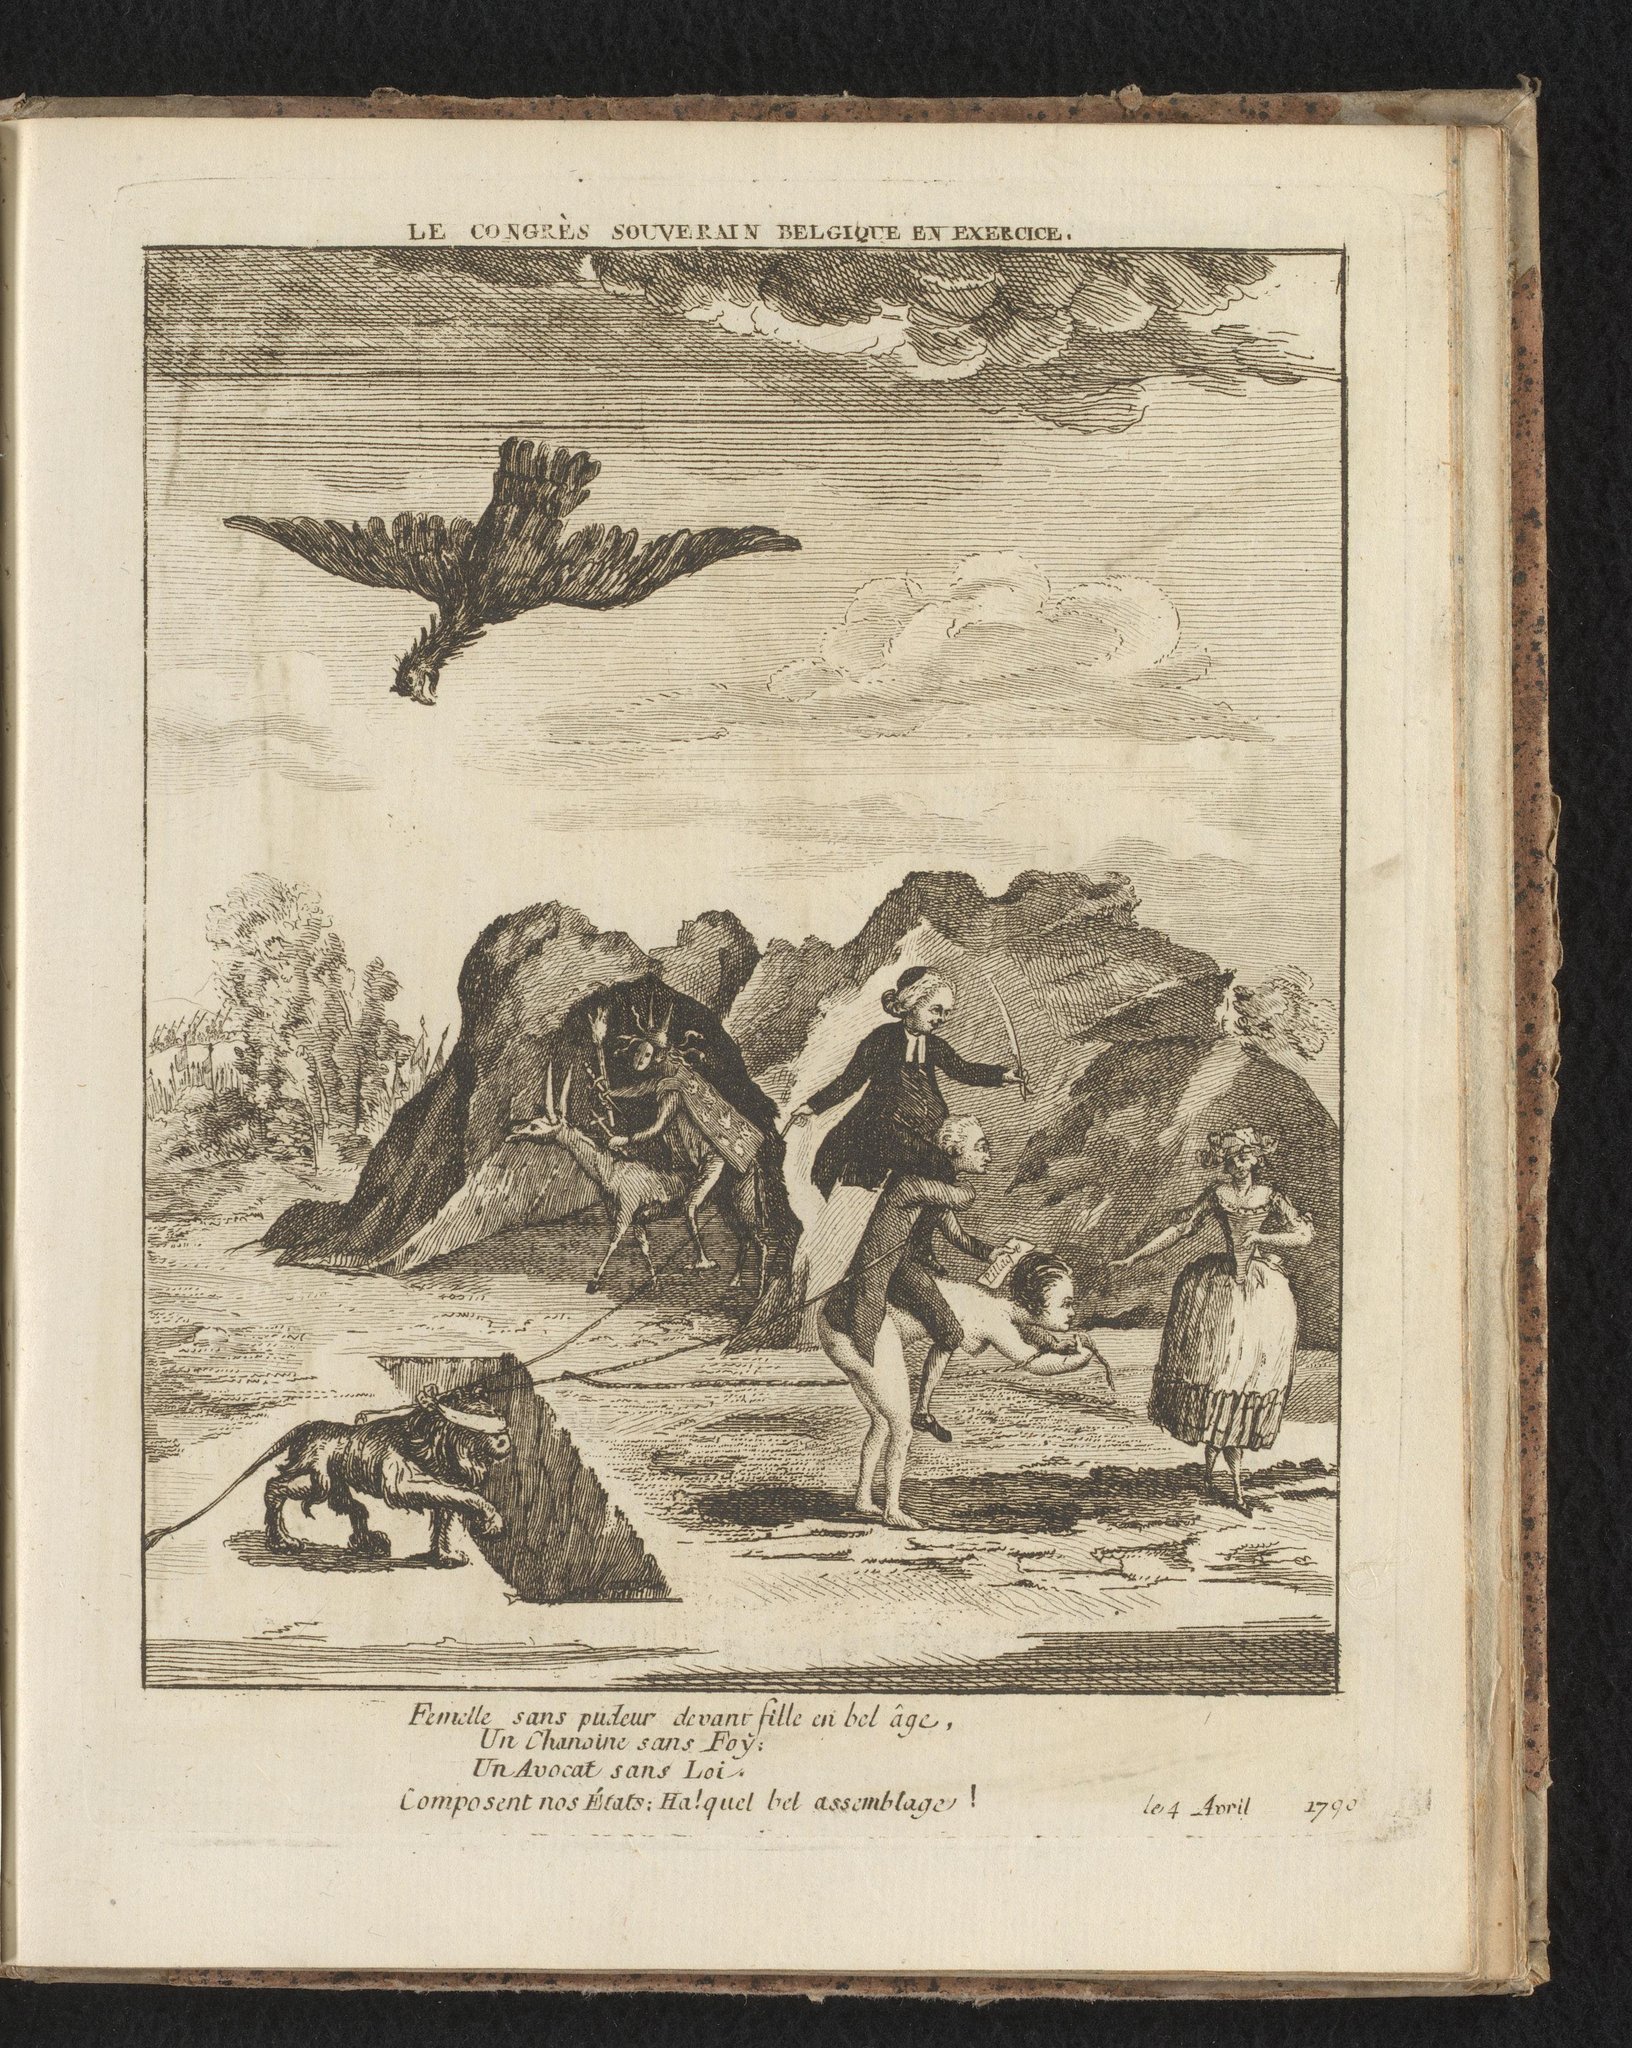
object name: cartoon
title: Le Congrès Souverain Belgique en Exercice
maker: Anonymous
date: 1787-1790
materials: paper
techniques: engraving, etching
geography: southern netherlands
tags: brussels, politician, antwerp, priest, brabant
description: Spotprent waarin Hendrik van der Noot en Petrus van Eupen zitten op de rug van een naakte vrouw. Zij zijn met kettingen verbonden aan de geblinddoekte Brabantse leeuw en worden door een jonge vrouw (Madame Pinau?) gelokt waardoor de blinde leeuw in een kuil dreigt te stappen. In de lucht de Oostenrijkse adelaar (zonder de boeien in de bek). Op de achtergrond een duivel op een ezel in een grot. Met vierreglig Frans onderschrift. Hierbij de datum 4 april 1790. Onderdeel van de gebundelde verzameling prenten betrekking hebbend op de gebeurtenissen van de Brabantse Omwenteling en de periode 1787-1790.